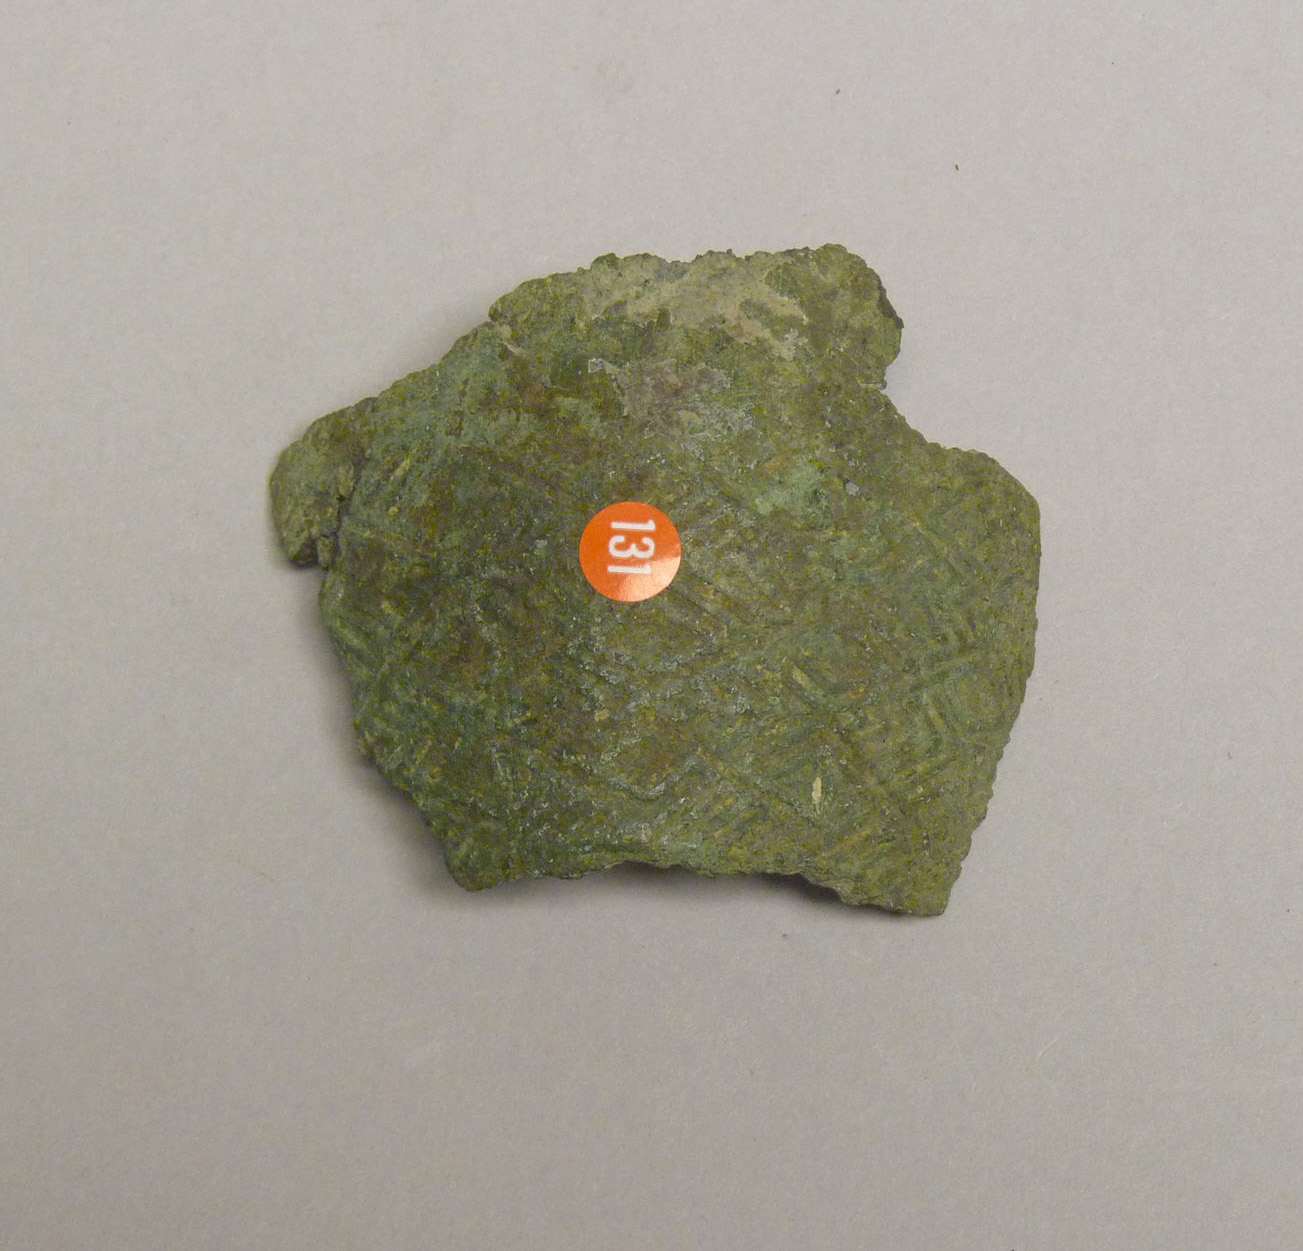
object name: motif fragment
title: Fragment with Basketweave Motif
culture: indonesian, javanese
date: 500 BCE-300 CE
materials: bronze